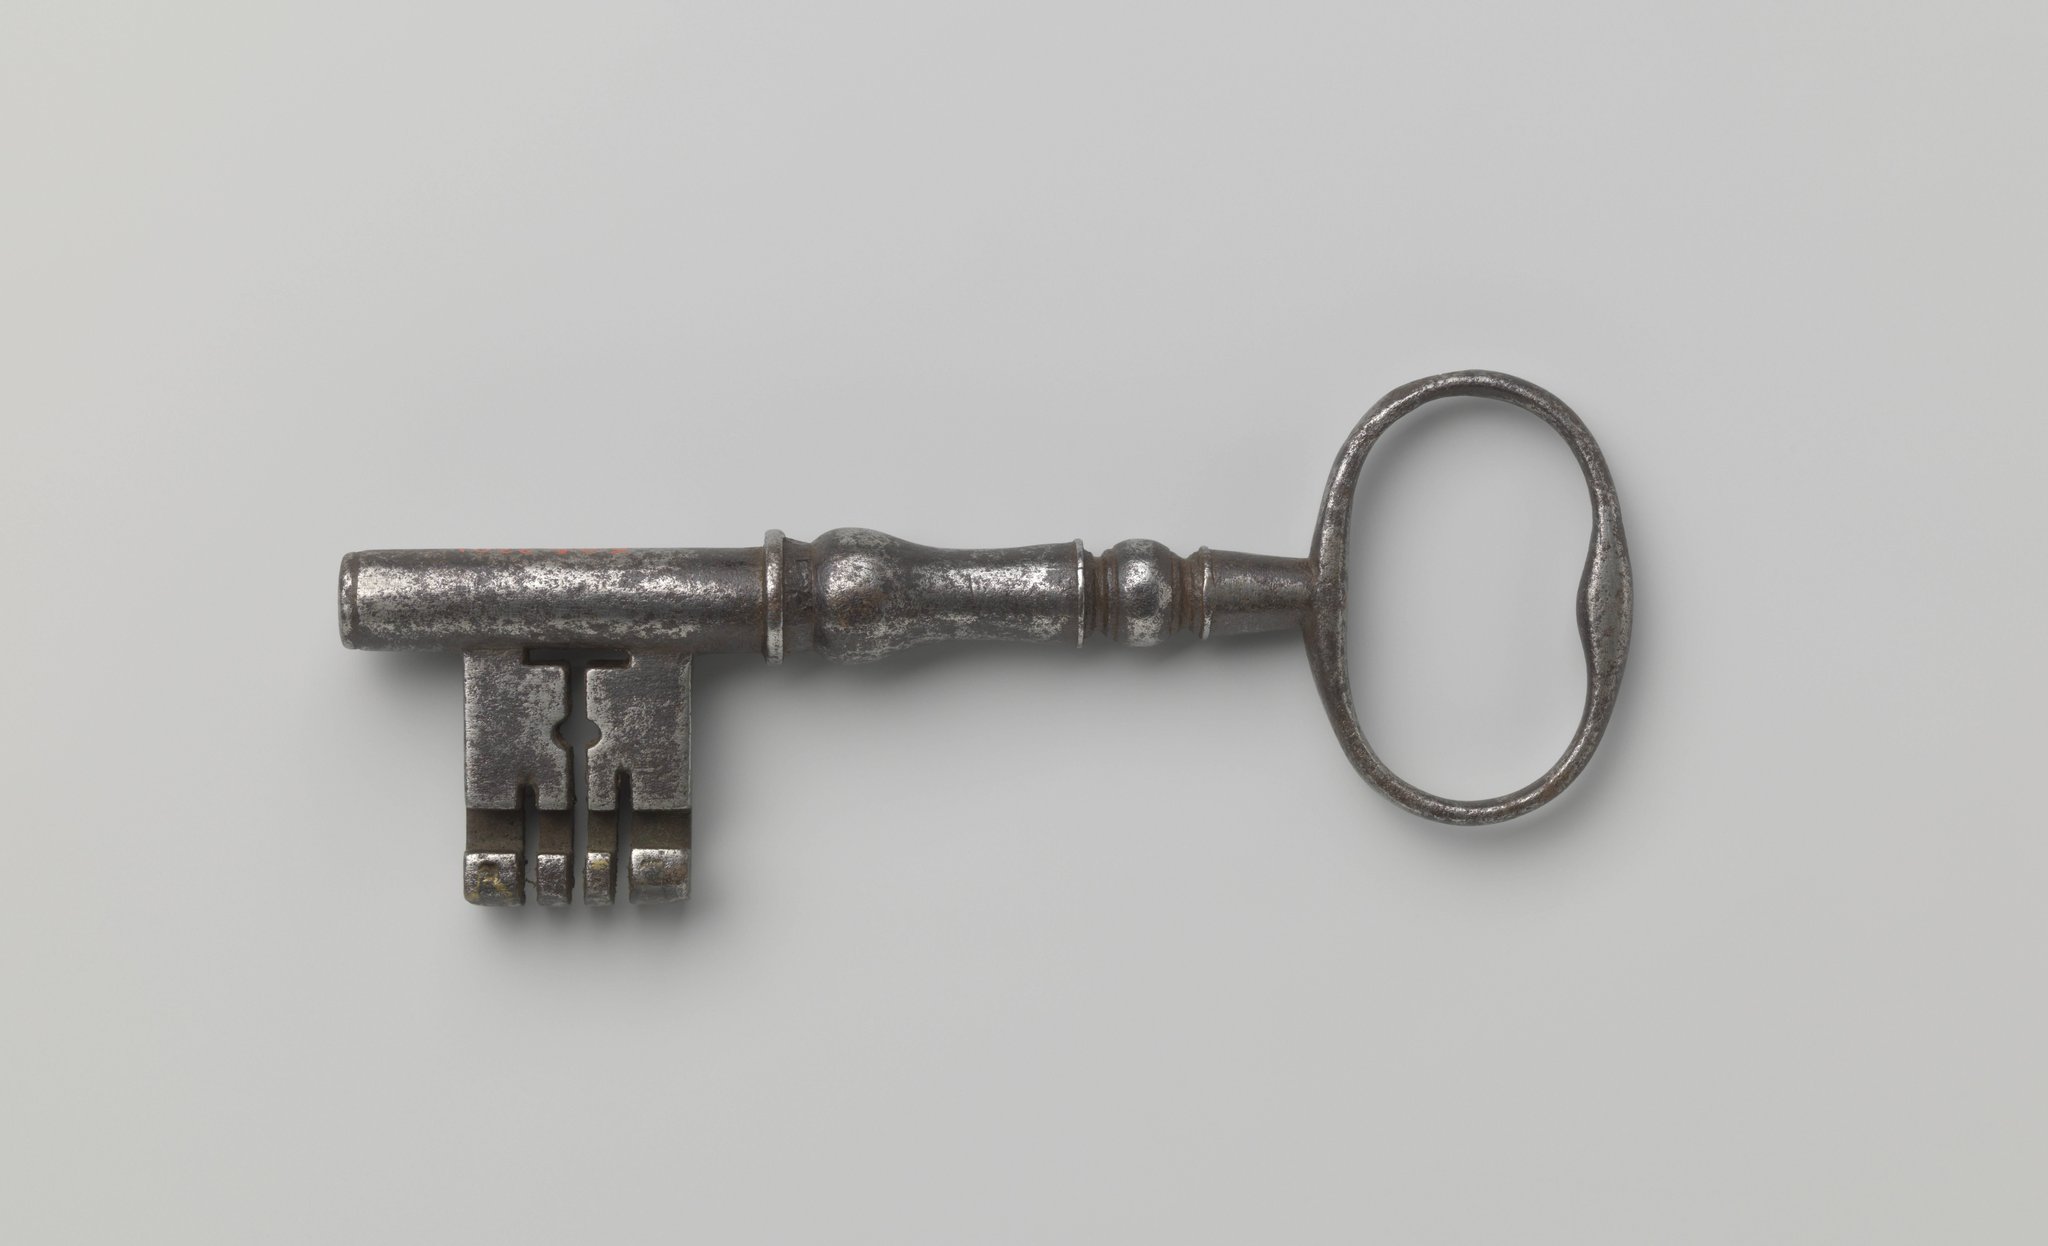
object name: key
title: Sleutel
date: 1600-1699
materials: iron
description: Sleutel waarvan de schacht tot aan de sleutelborst baluster-vormig is en voorbij de baard doorlopend. Het oog is ovaal met bovenaan een verdikking.